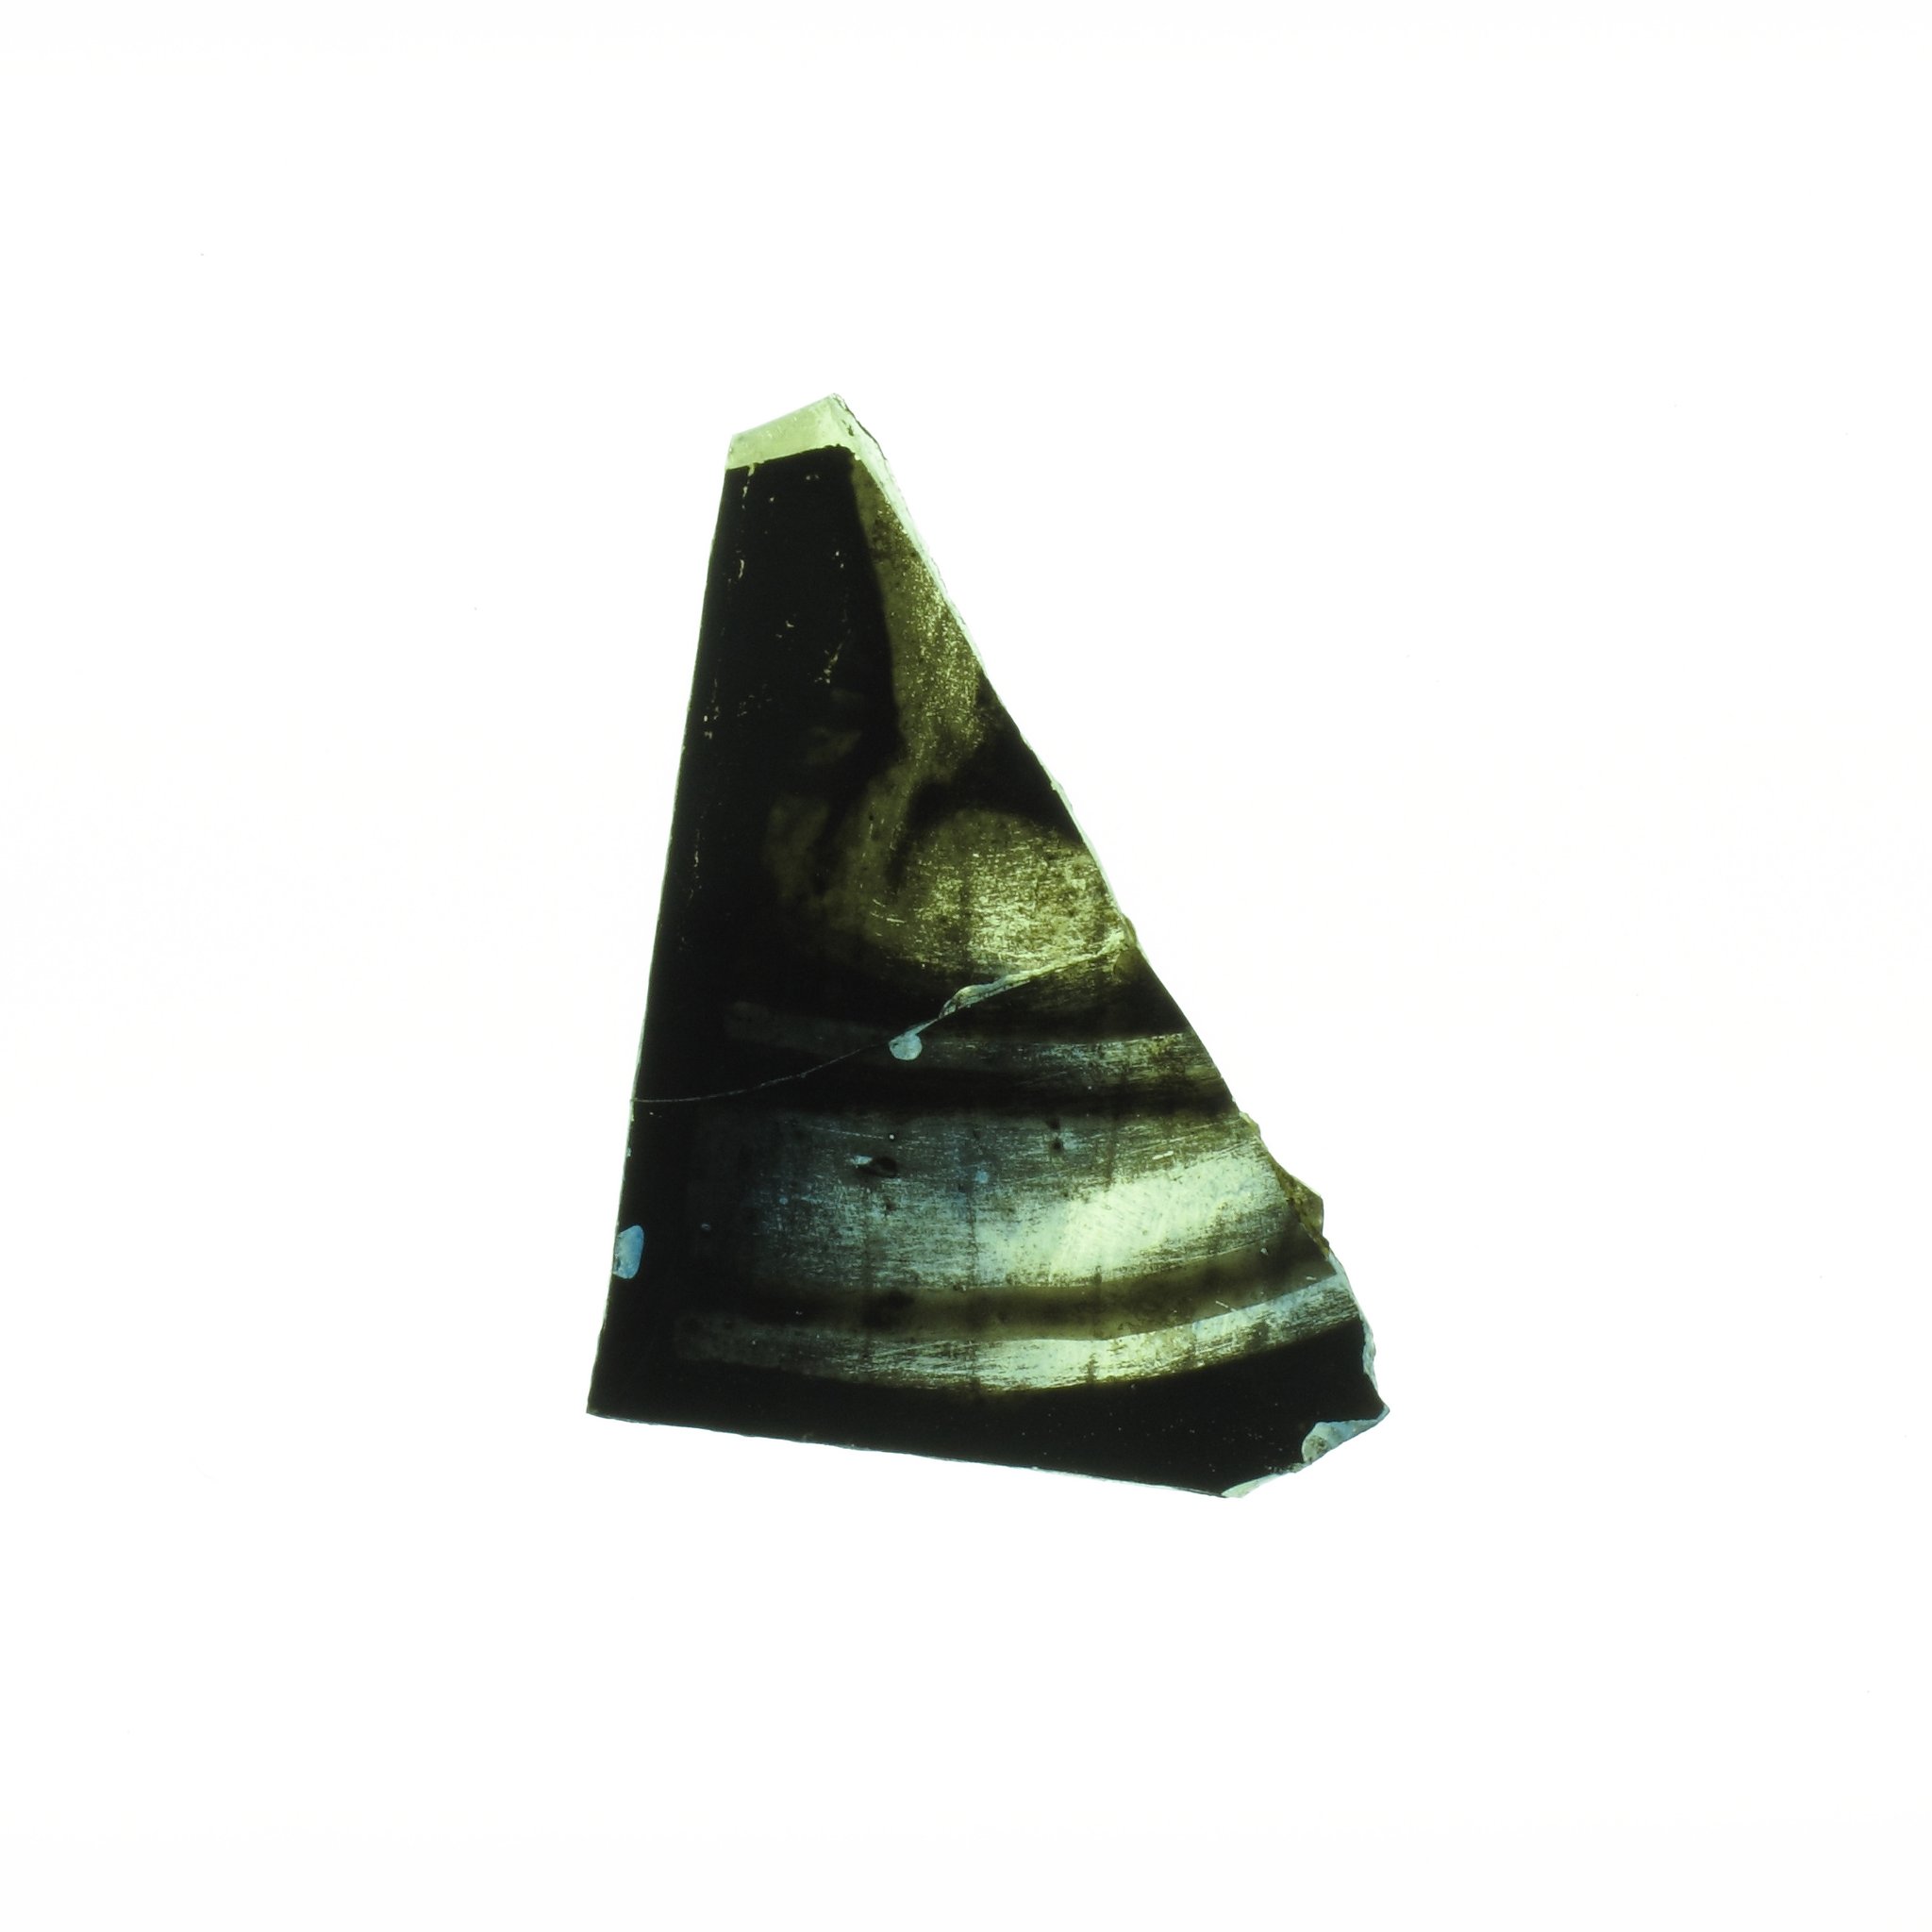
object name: fragment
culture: french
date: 1101-1400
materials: glass, metal, paint